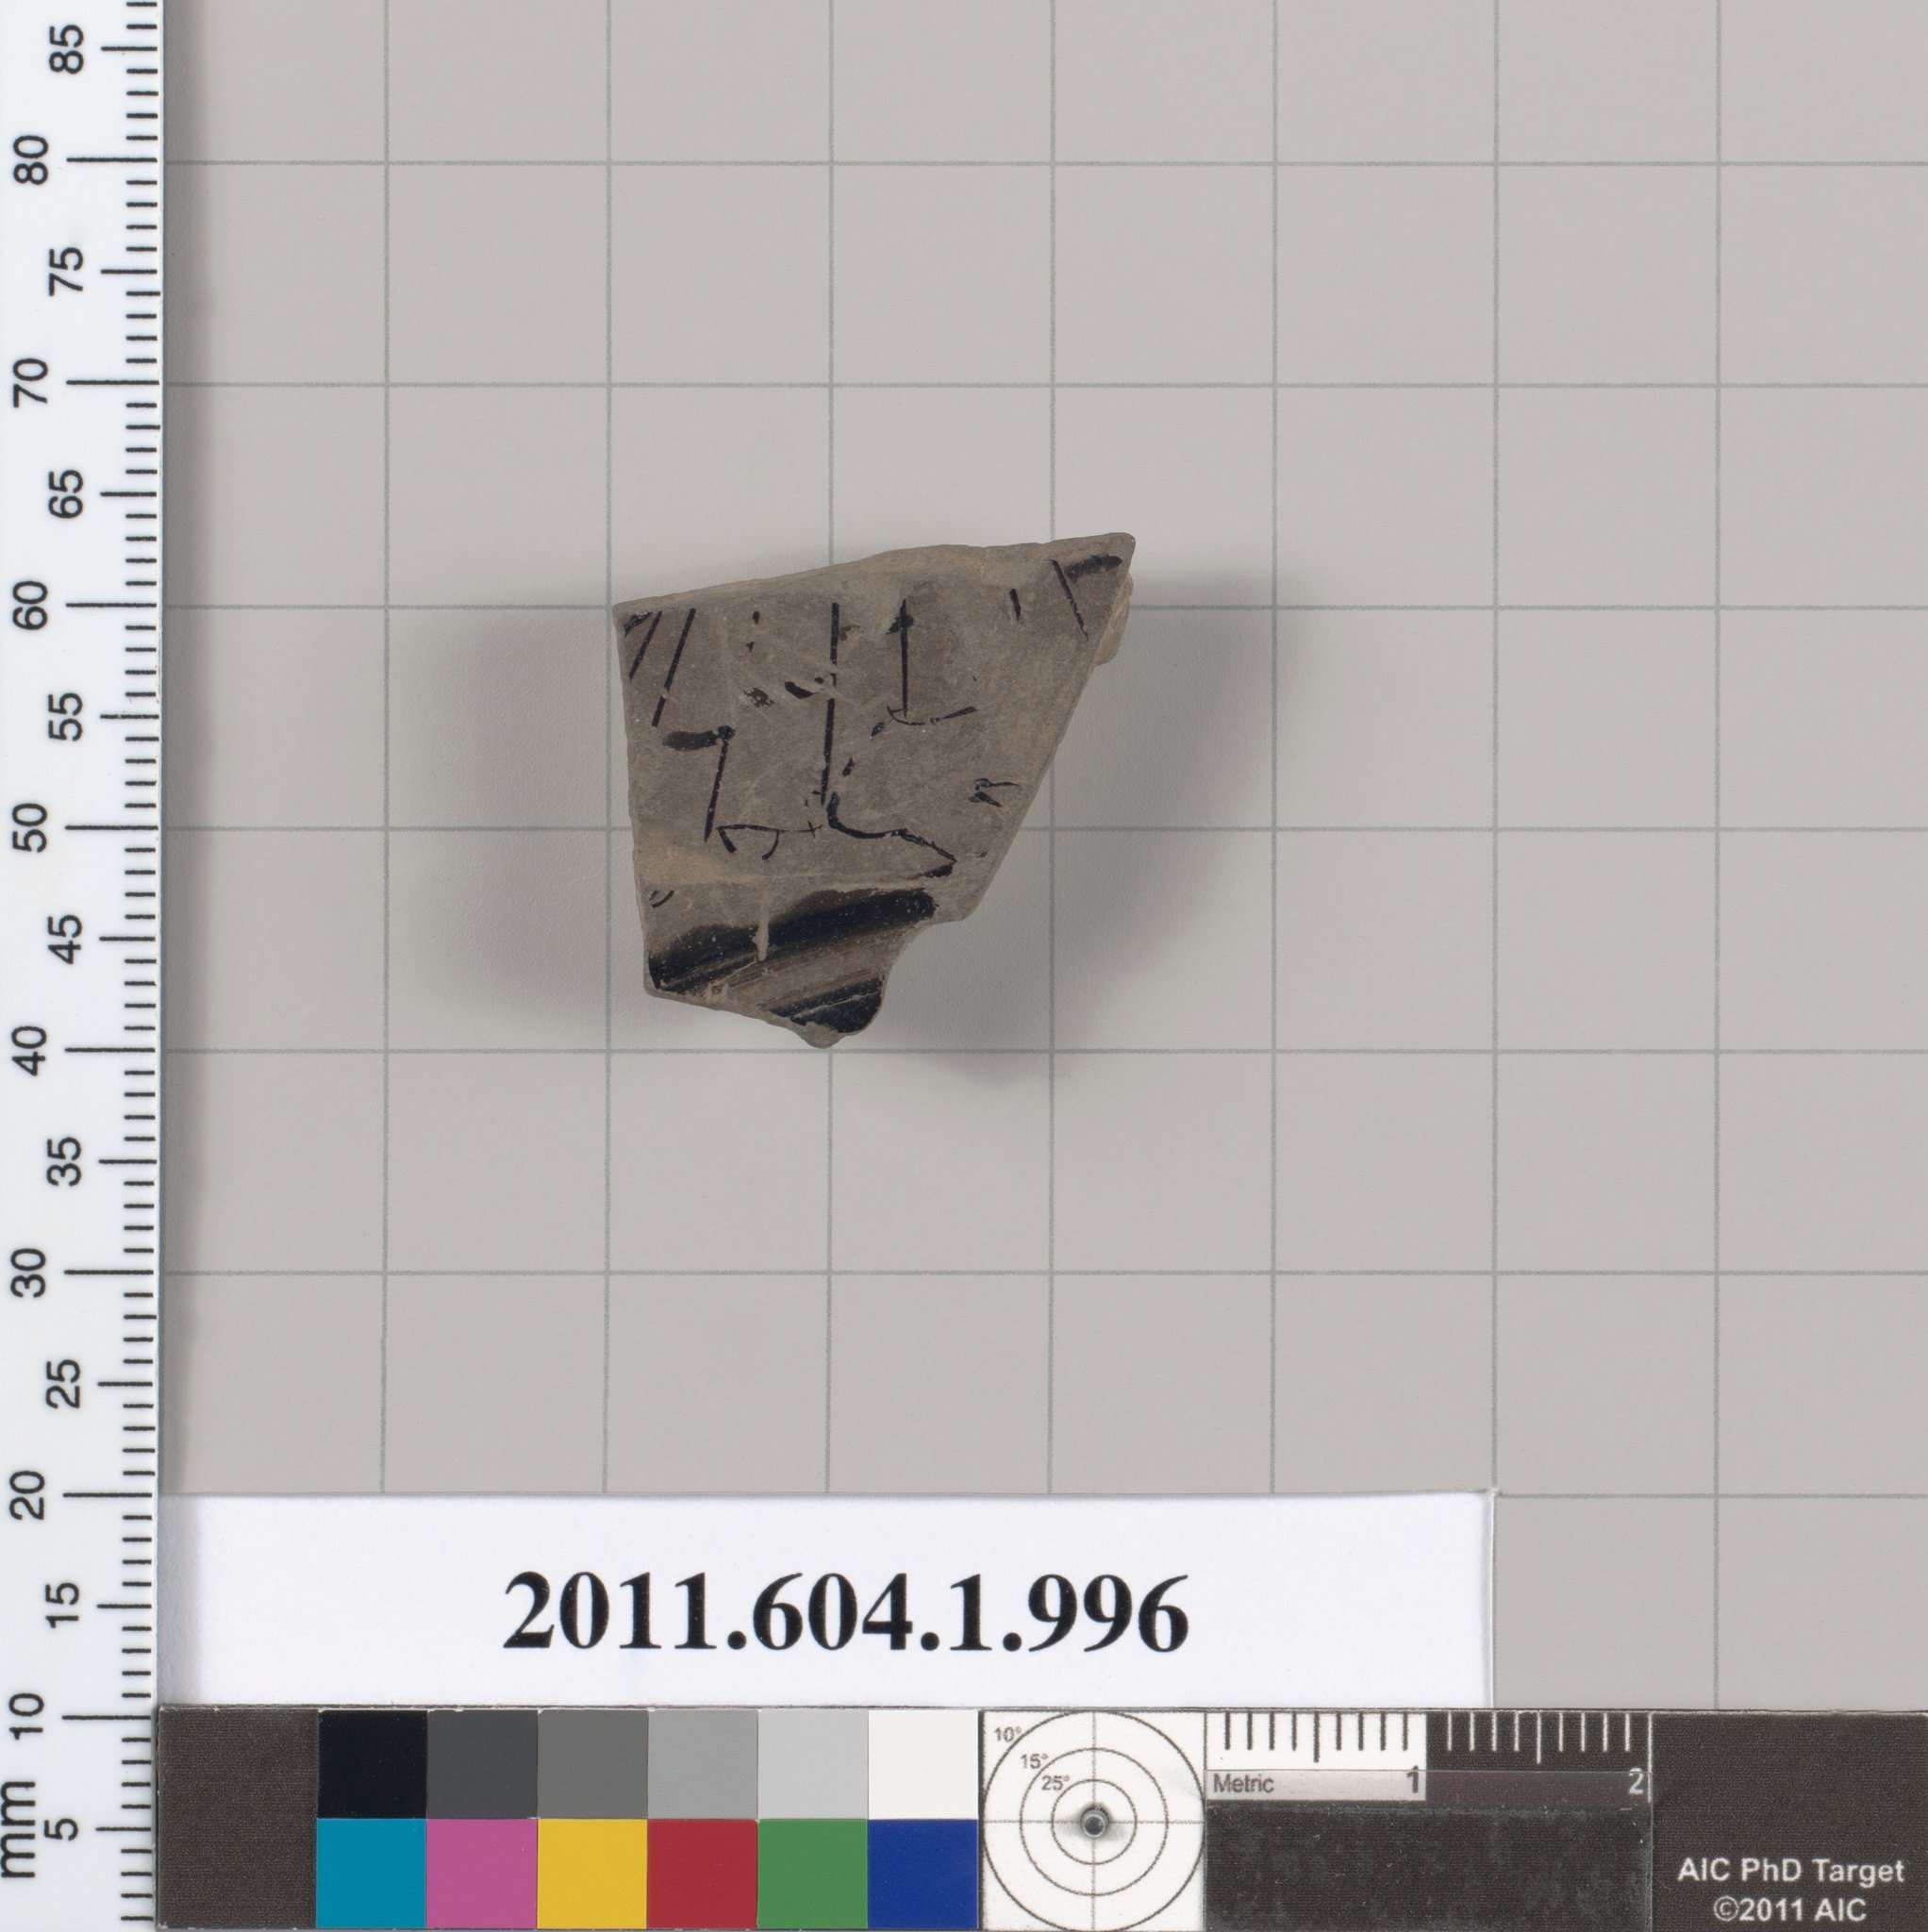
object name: kylix fragment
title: Terracotta fragment of a kylix (drinking cup)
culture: greek, attic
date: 475-451 BCE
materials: terracotta